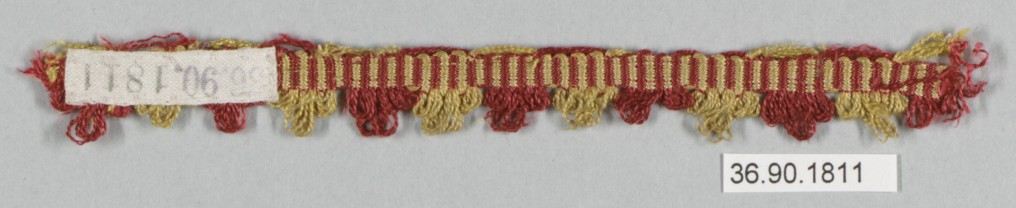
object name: fringe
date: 1767-1800